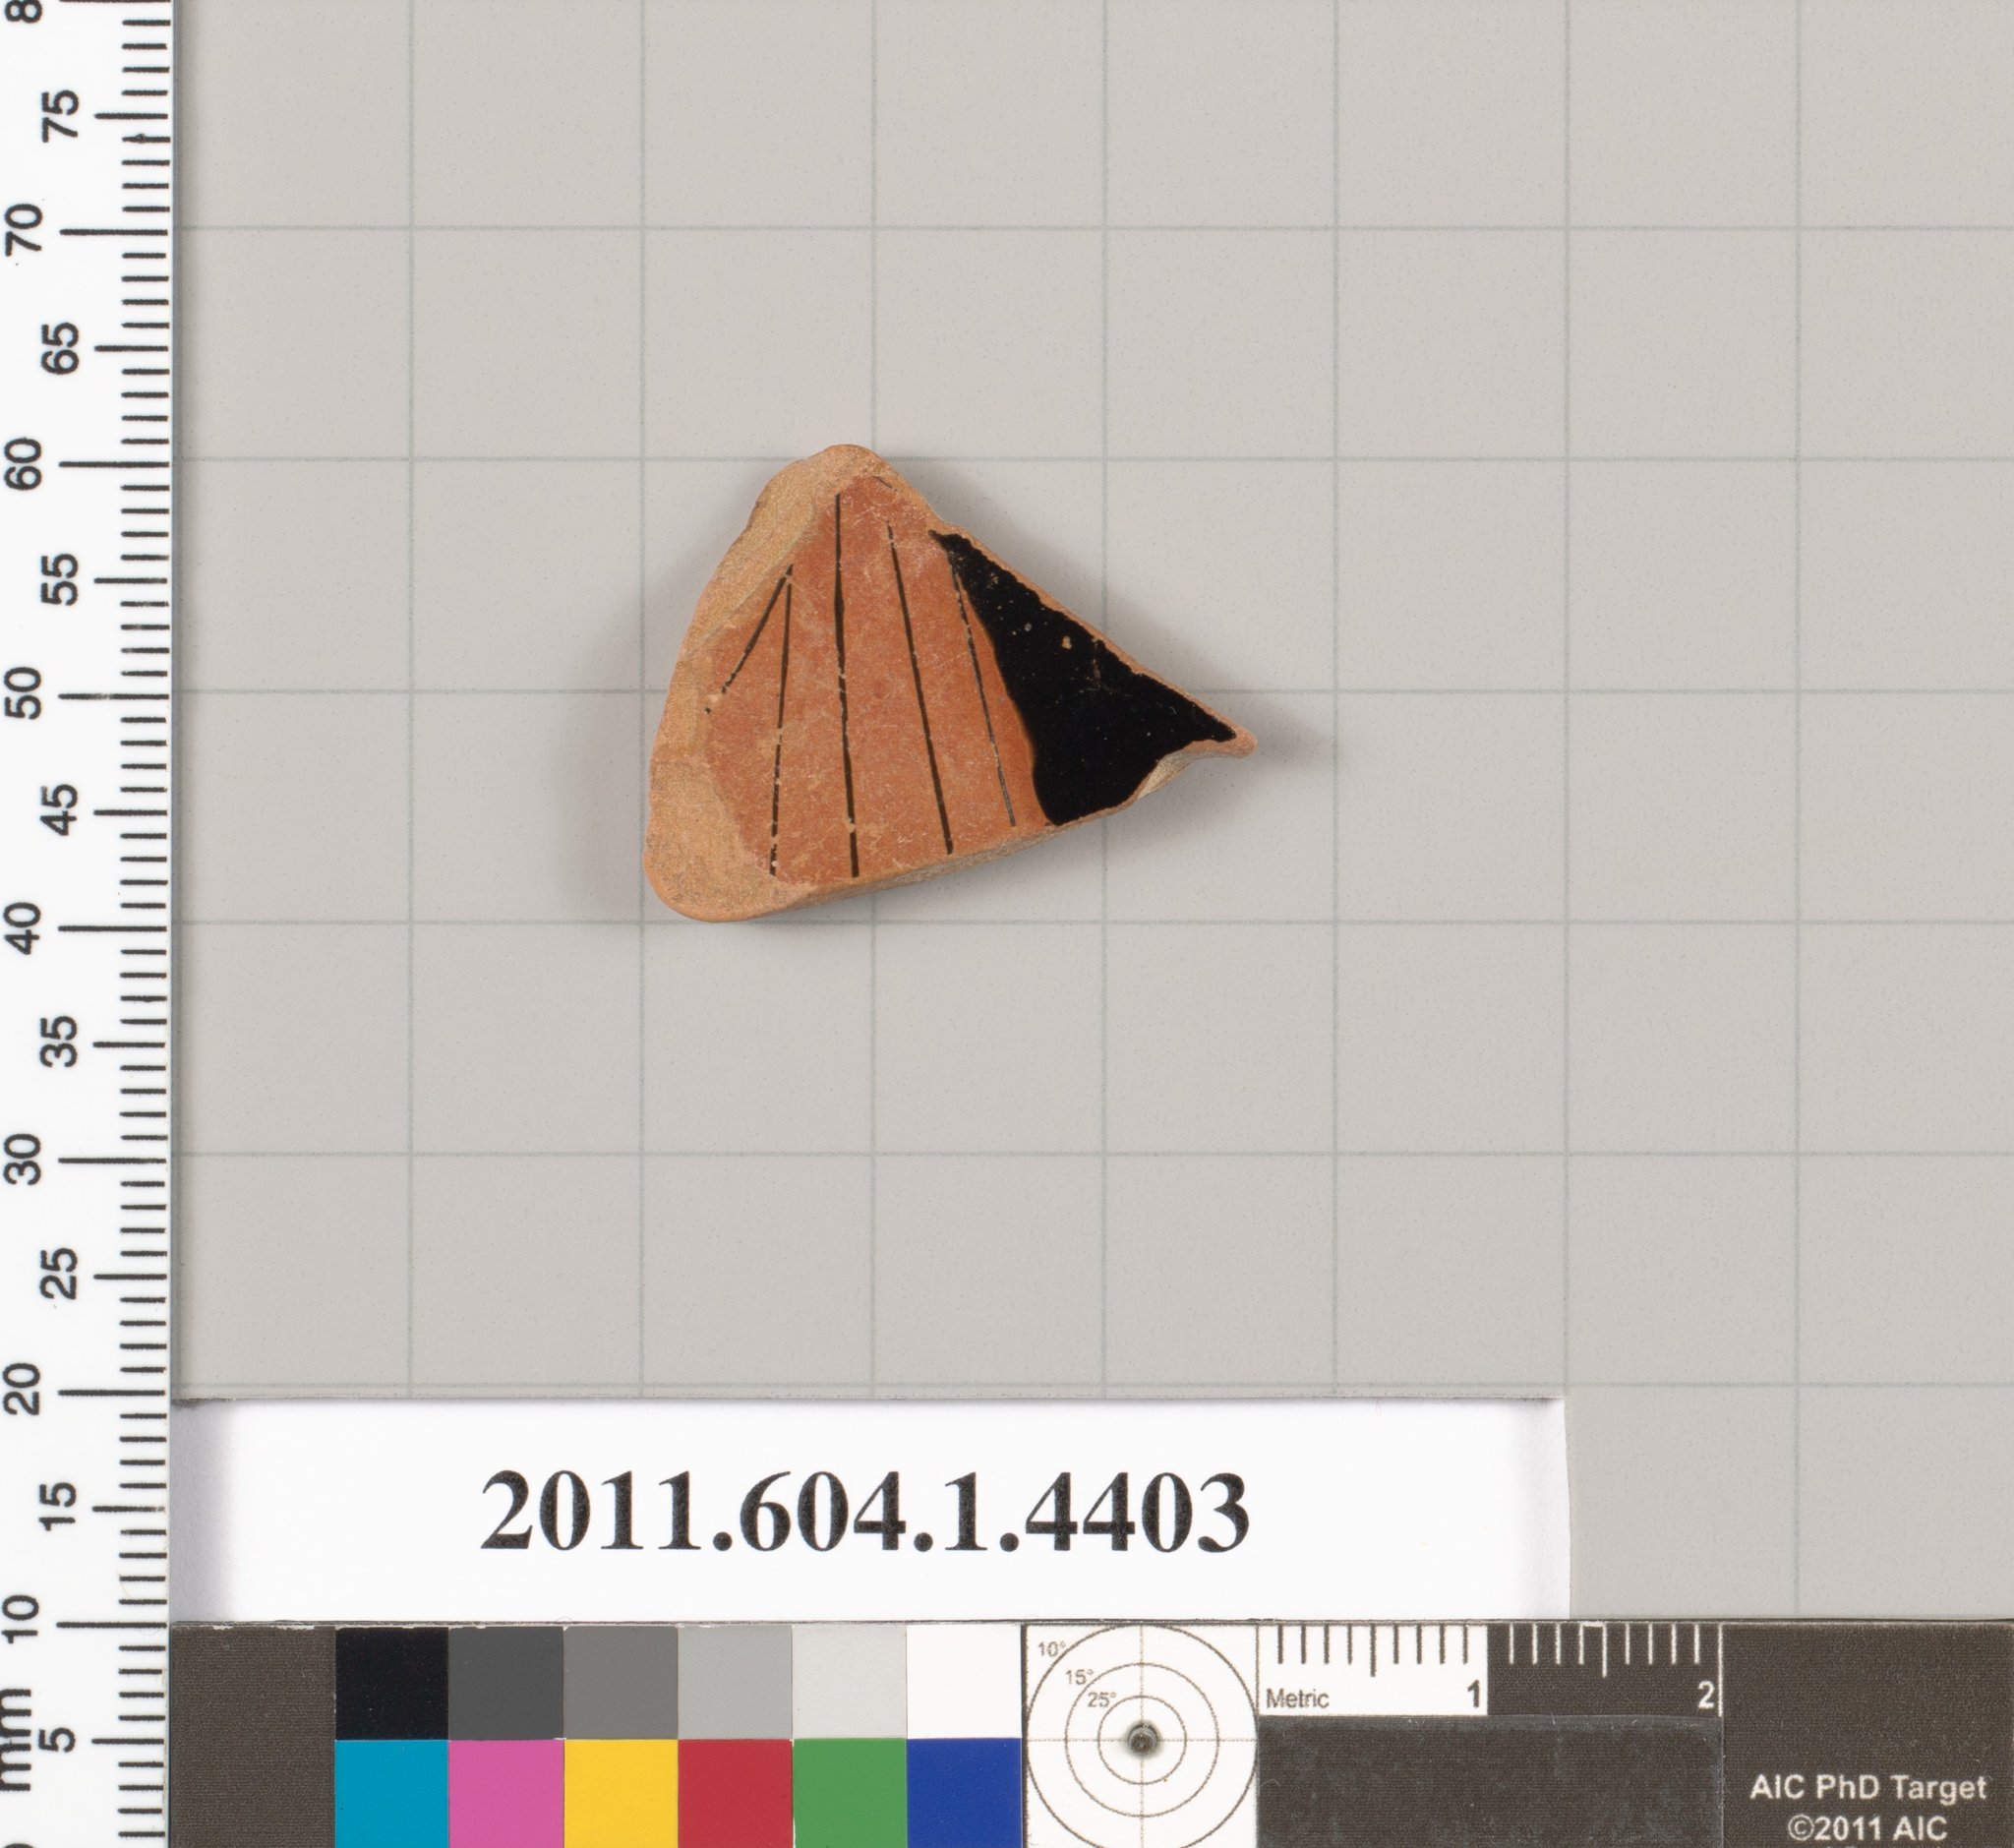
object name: kylix fragment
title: Terracotta fragment of a kylix (drinking cup)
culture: greek, attic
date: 475-451 BCE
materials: terracotta